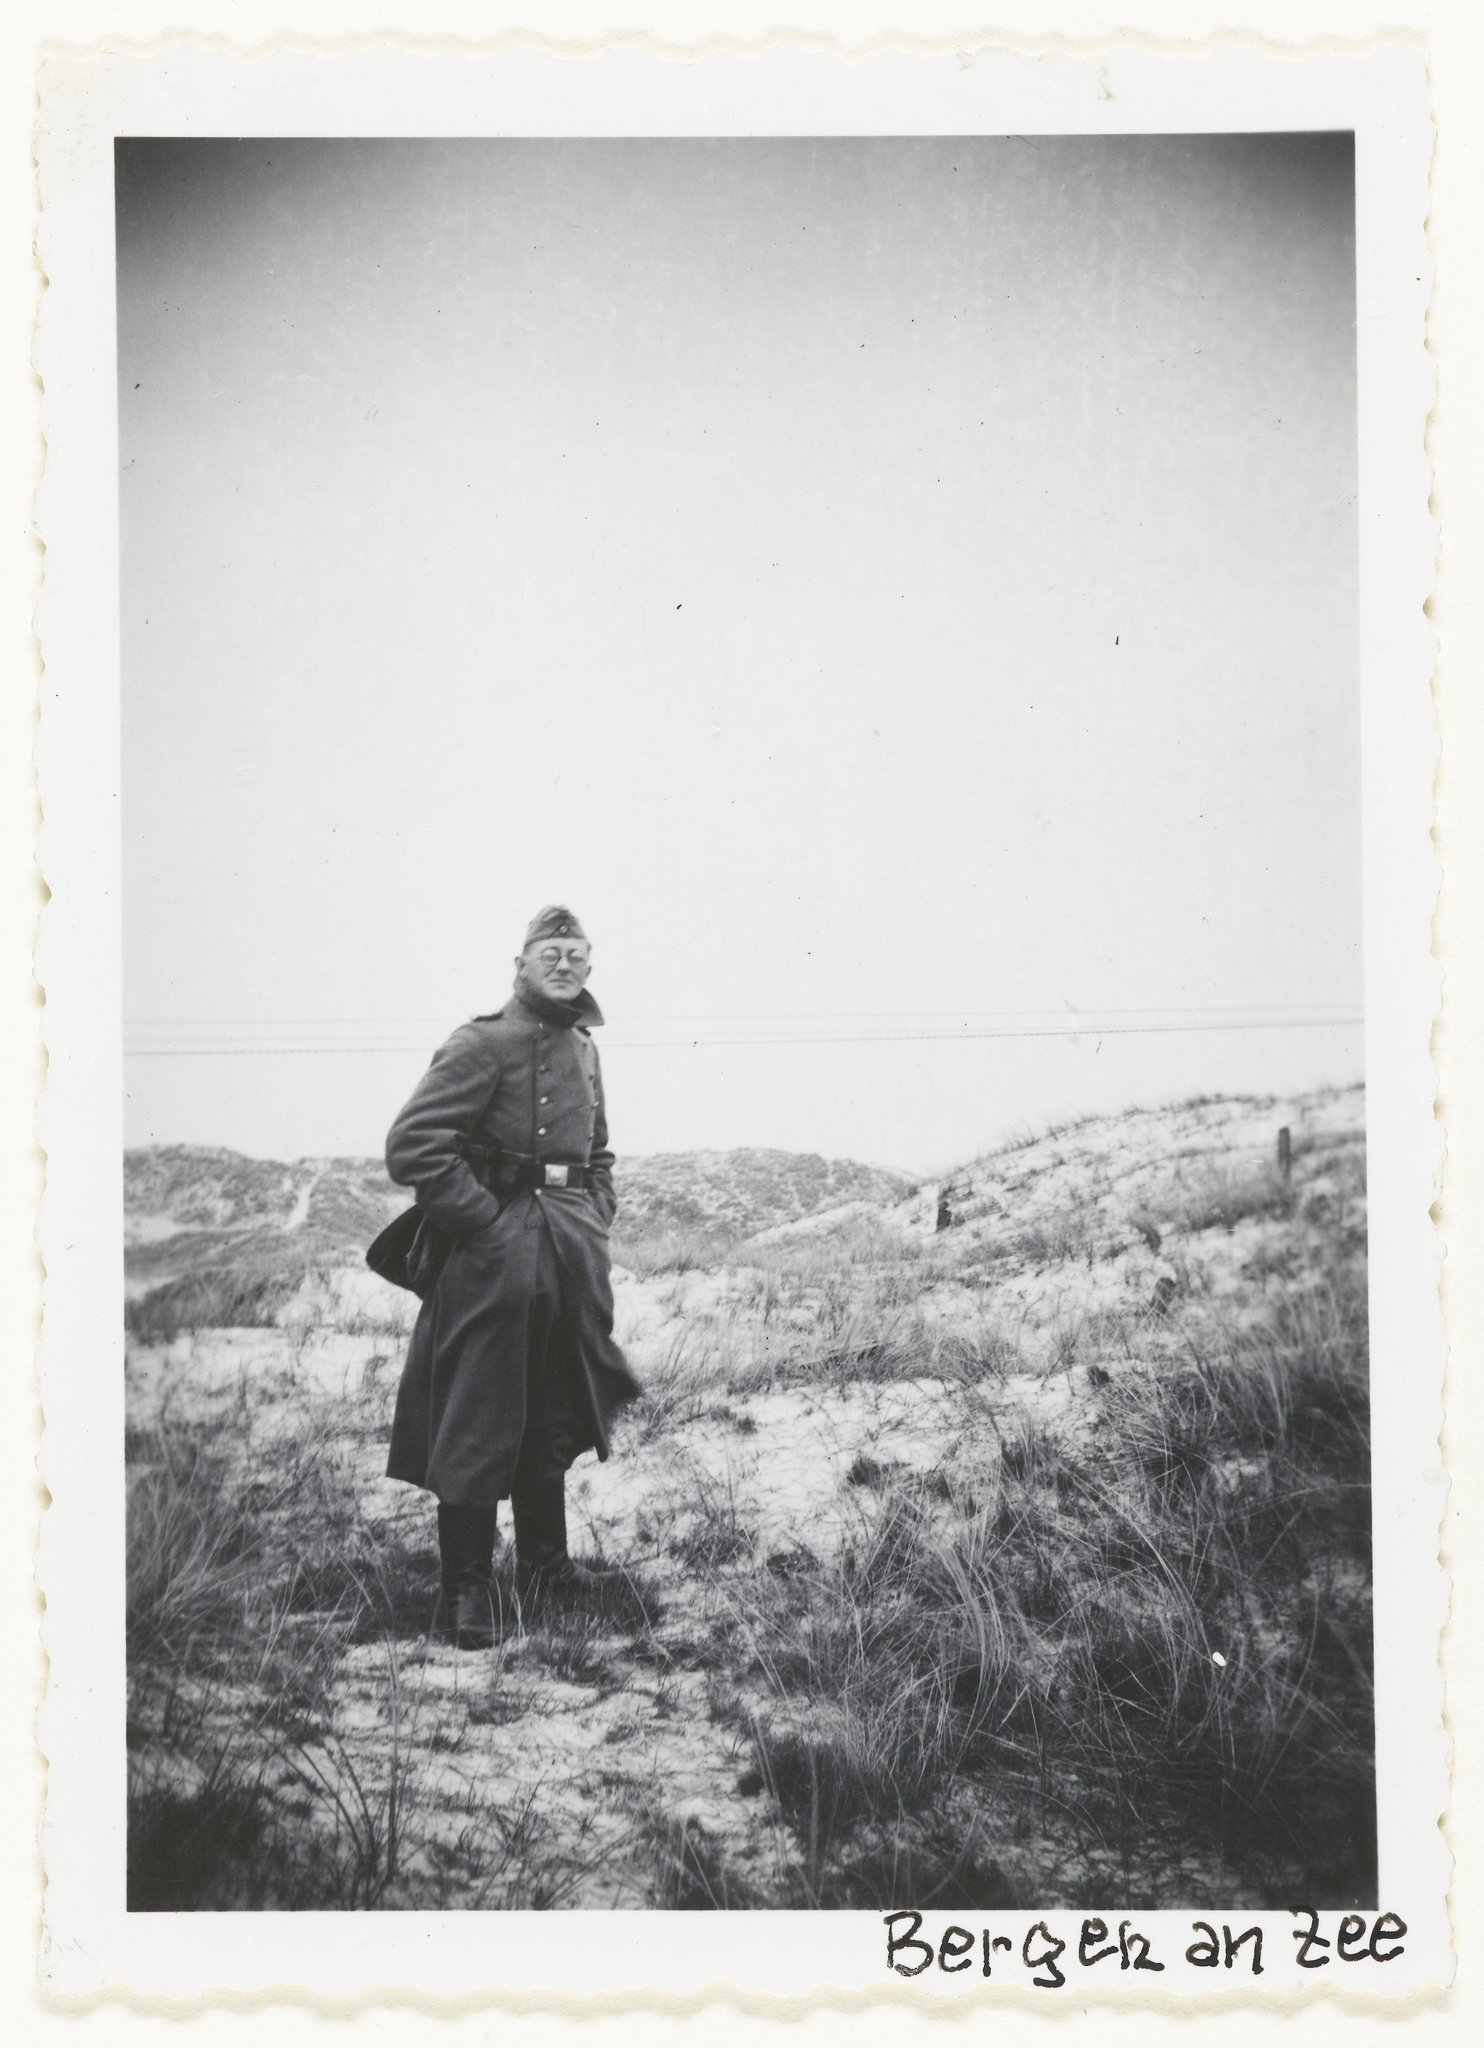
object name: photograph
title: Wehrmacht soldaat in de duinen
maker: Anonymous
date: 1940-1941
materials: photographic support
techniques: gelatin silver print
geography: bergen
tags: occupation ~ war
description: Een Wehrmacht soldaat staat in de duinen dicht bij zee. Zijn jas waait op. Hij draagt een bril